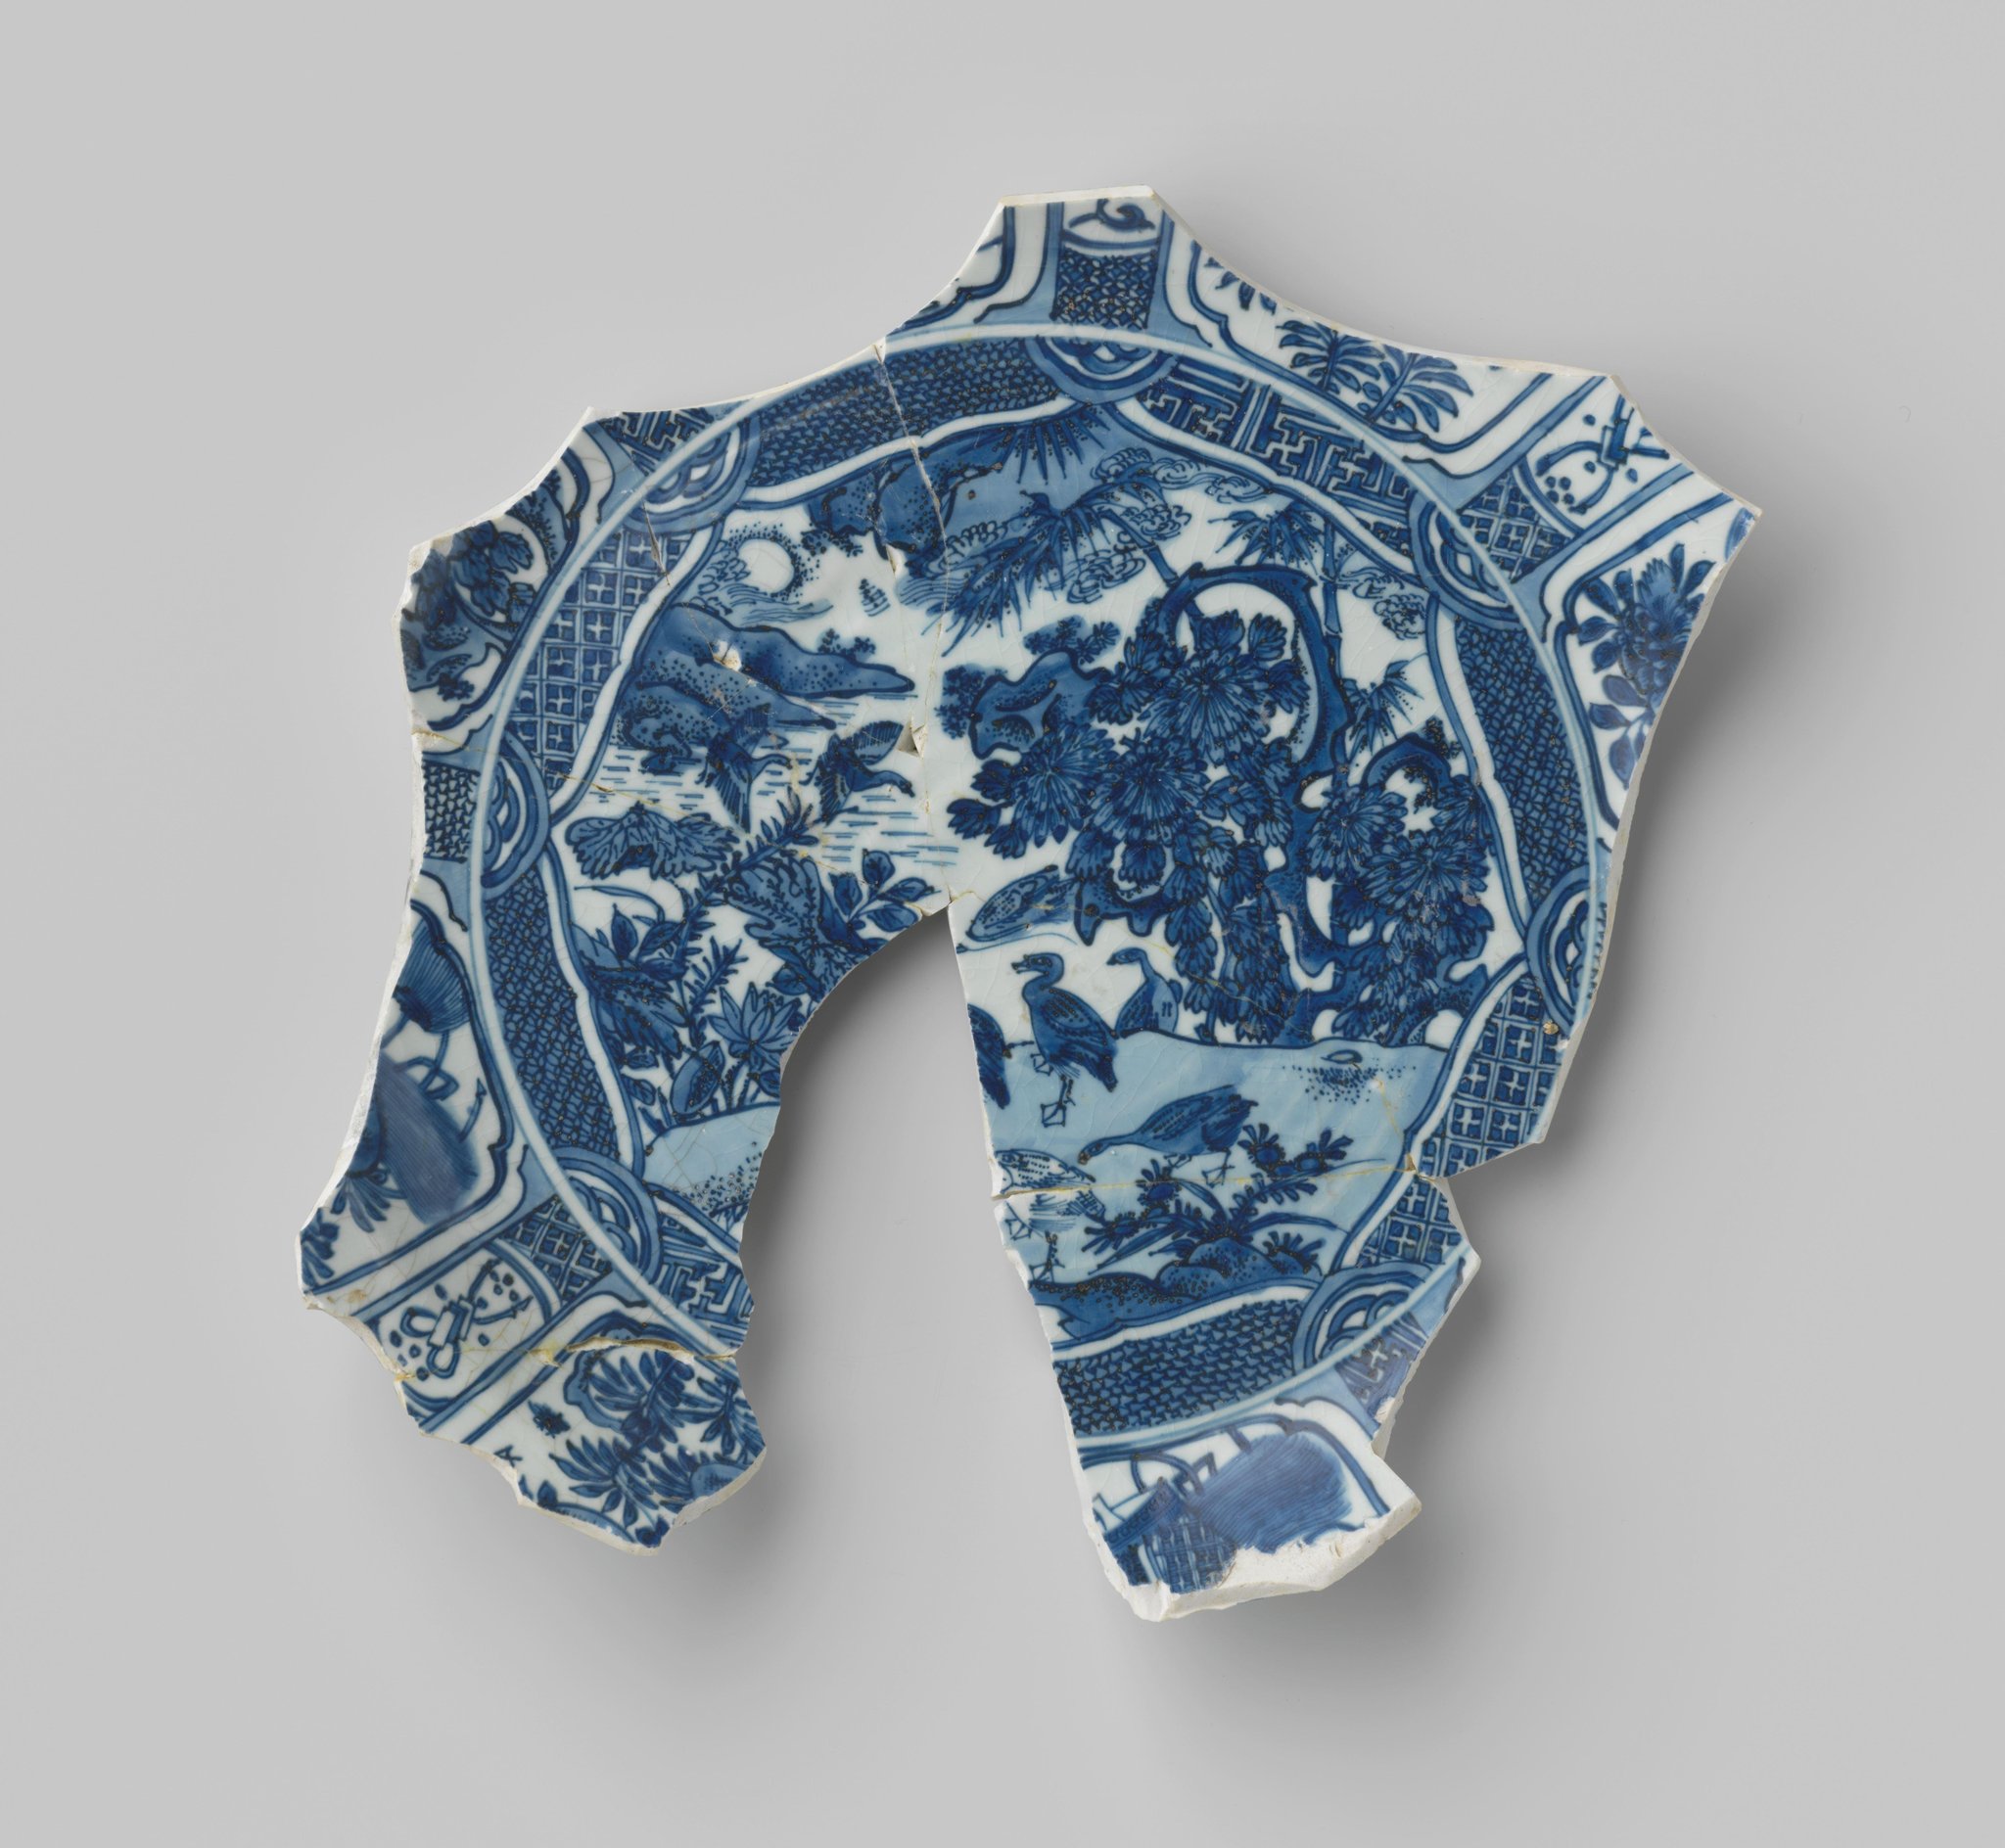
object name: washbowl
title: Fragment schotel uit V.O.C.-schip de 'Witte Leeuw'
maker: Anonymous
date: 1613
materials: bone china, glaze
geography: jingdezhen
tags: verenigde oostindische compagnie, sint-helena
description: Fragment schotel uit V.O.C.-schip de 'Witte Leeuw', 50% aanwezig. De scherf is glasachtig wit en kent weinig ingebakken vuil. Het glazuur is blauw getint en bladdert over gedeelten van de liprand af. De bodem is ongeglazuurd. De voetring is recht, gefacetteerd en staat naar binne. De lip is geschulpt. Lampetschotel. Acht aan elkaar gelijmde scherven.